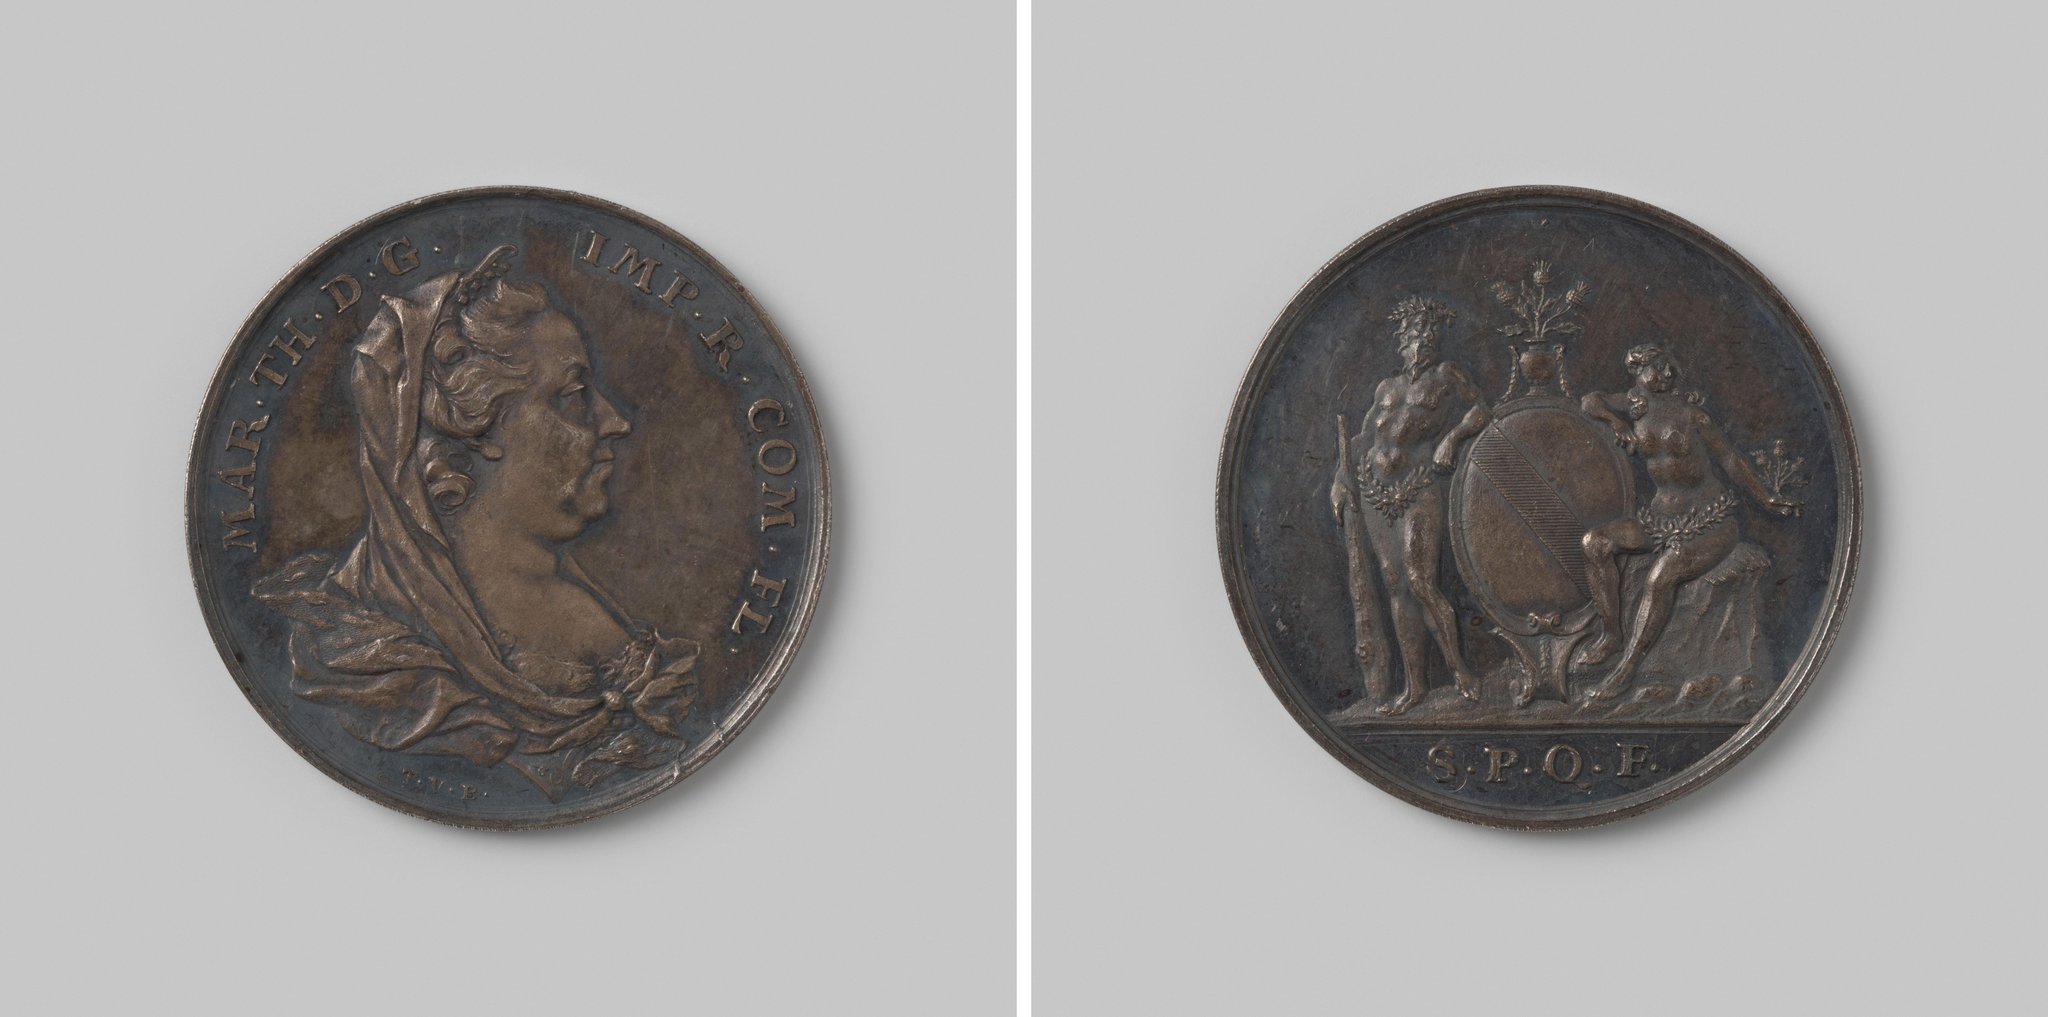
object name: history medal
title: Het Vrije van Brugge 1776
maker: theodorus victor van berckel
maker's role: mintmaster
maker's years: 1739-1808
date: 1776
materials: silver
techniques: striking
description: Zilveren penning, op de voorzijde het gesluierde portret van Maria Theresia met omschrift, op de keerzijde een ovaal wapenschild van het Vrije tussen een staande wildeman en een zittende vrouw, in afsnede SPQF.